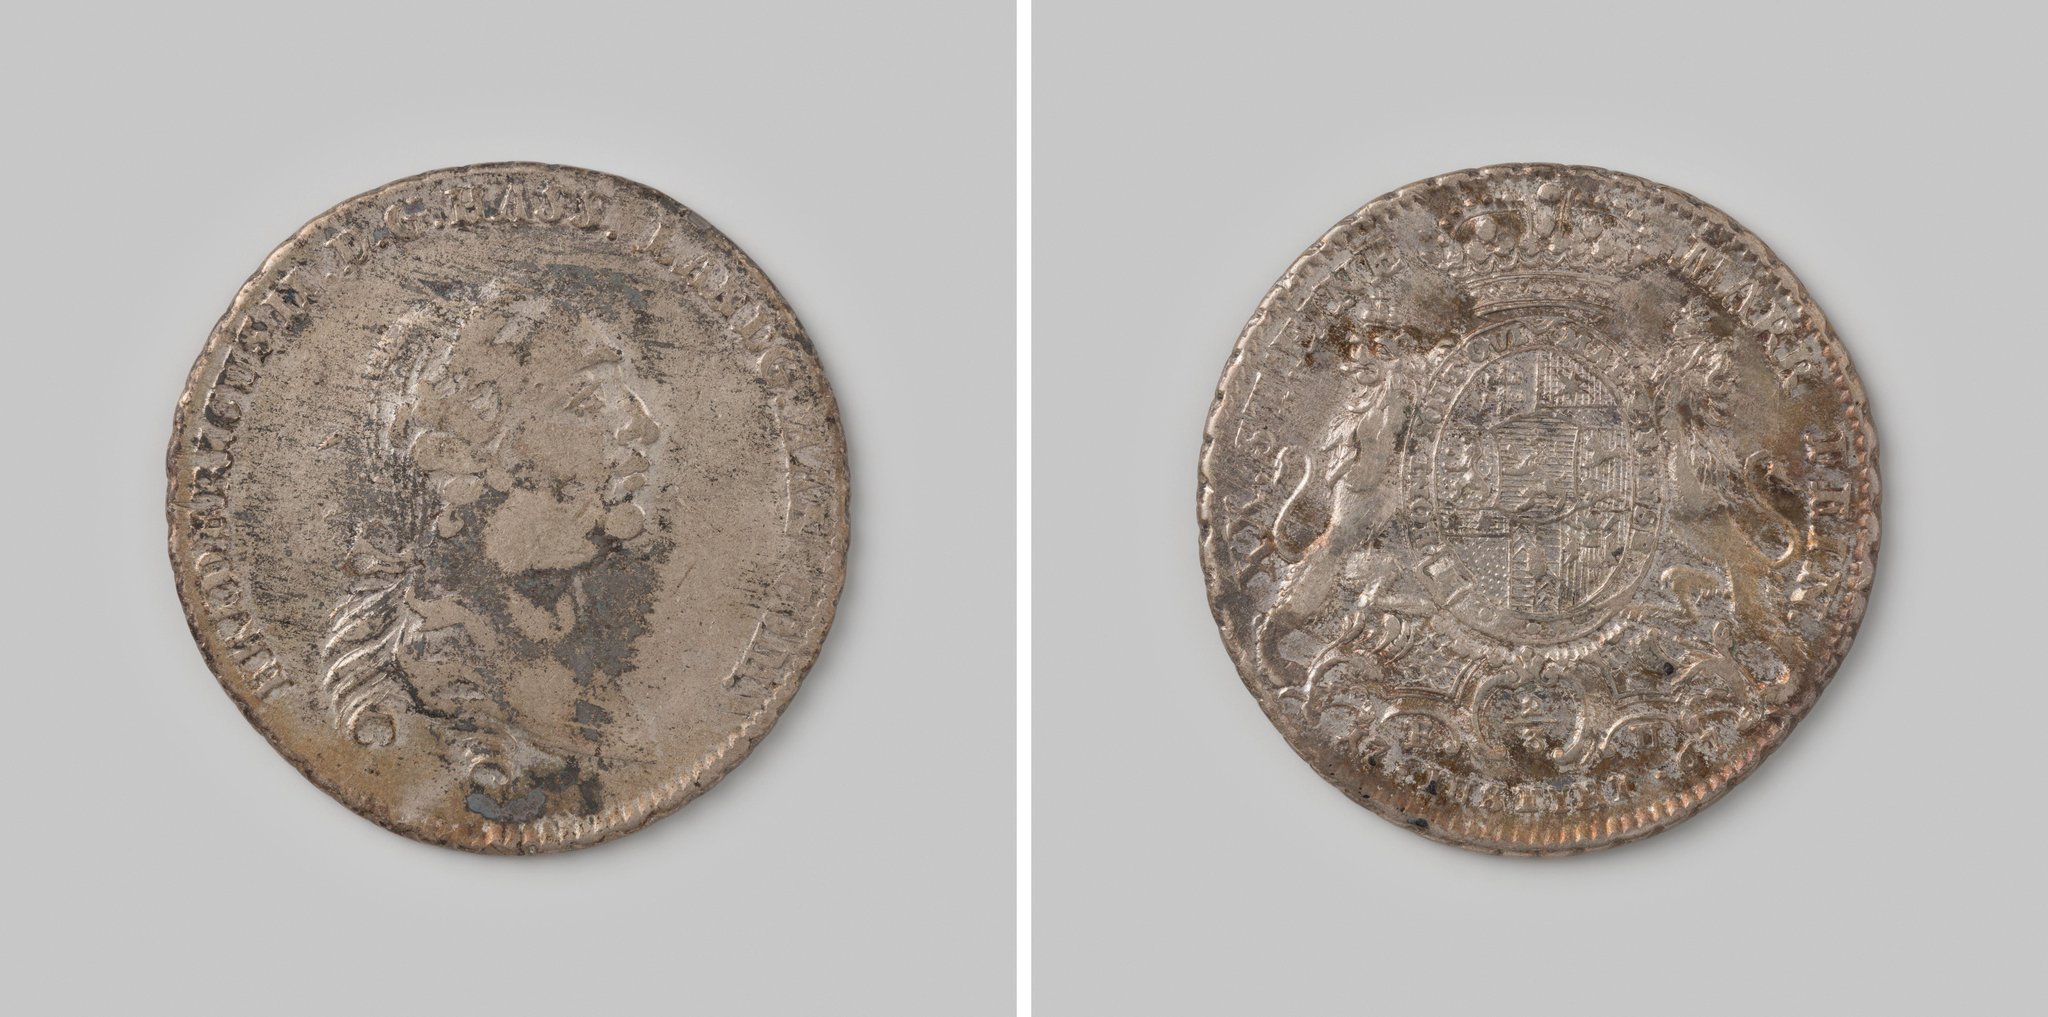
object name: coin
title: Hessen-Kassel, Friedrich II, 2/3 taler, 1767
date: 1767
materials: silver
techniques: striking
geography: kassel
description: Zilveren munt. Voorzijde: portret van de landgraaf naar rechts. Keerzijde: door twee leeuwen gehouden en met orde van de kousenband omhangen ovaal samengesteld wapenschild, waaronder waarde-aanduiding. Jaartal in omschrift. Bloemrand.